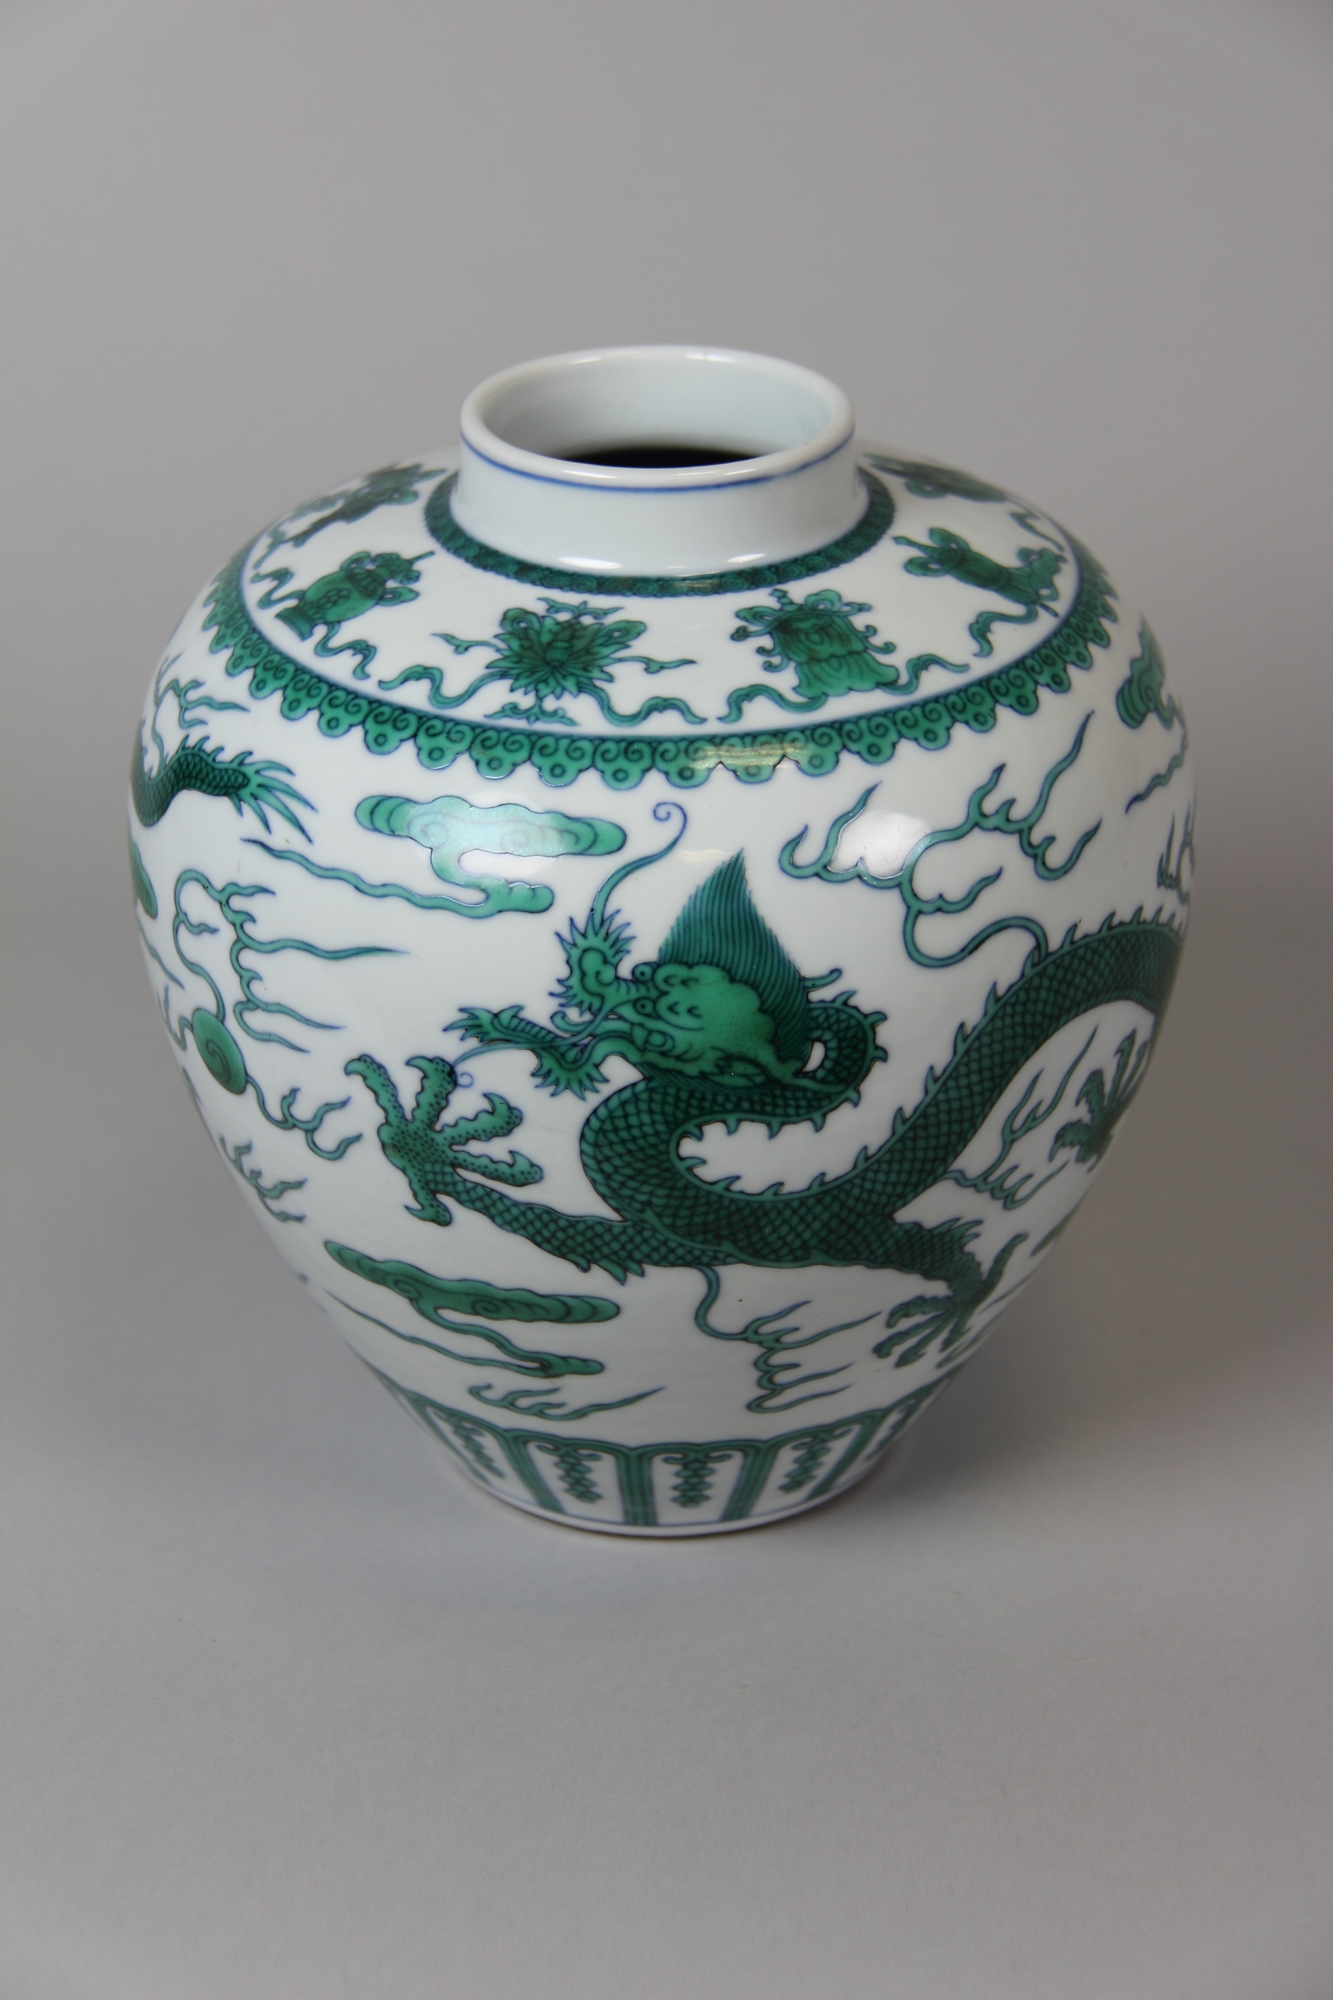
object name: jar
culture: chinese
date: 1736-1795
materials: porcelain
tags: dragons